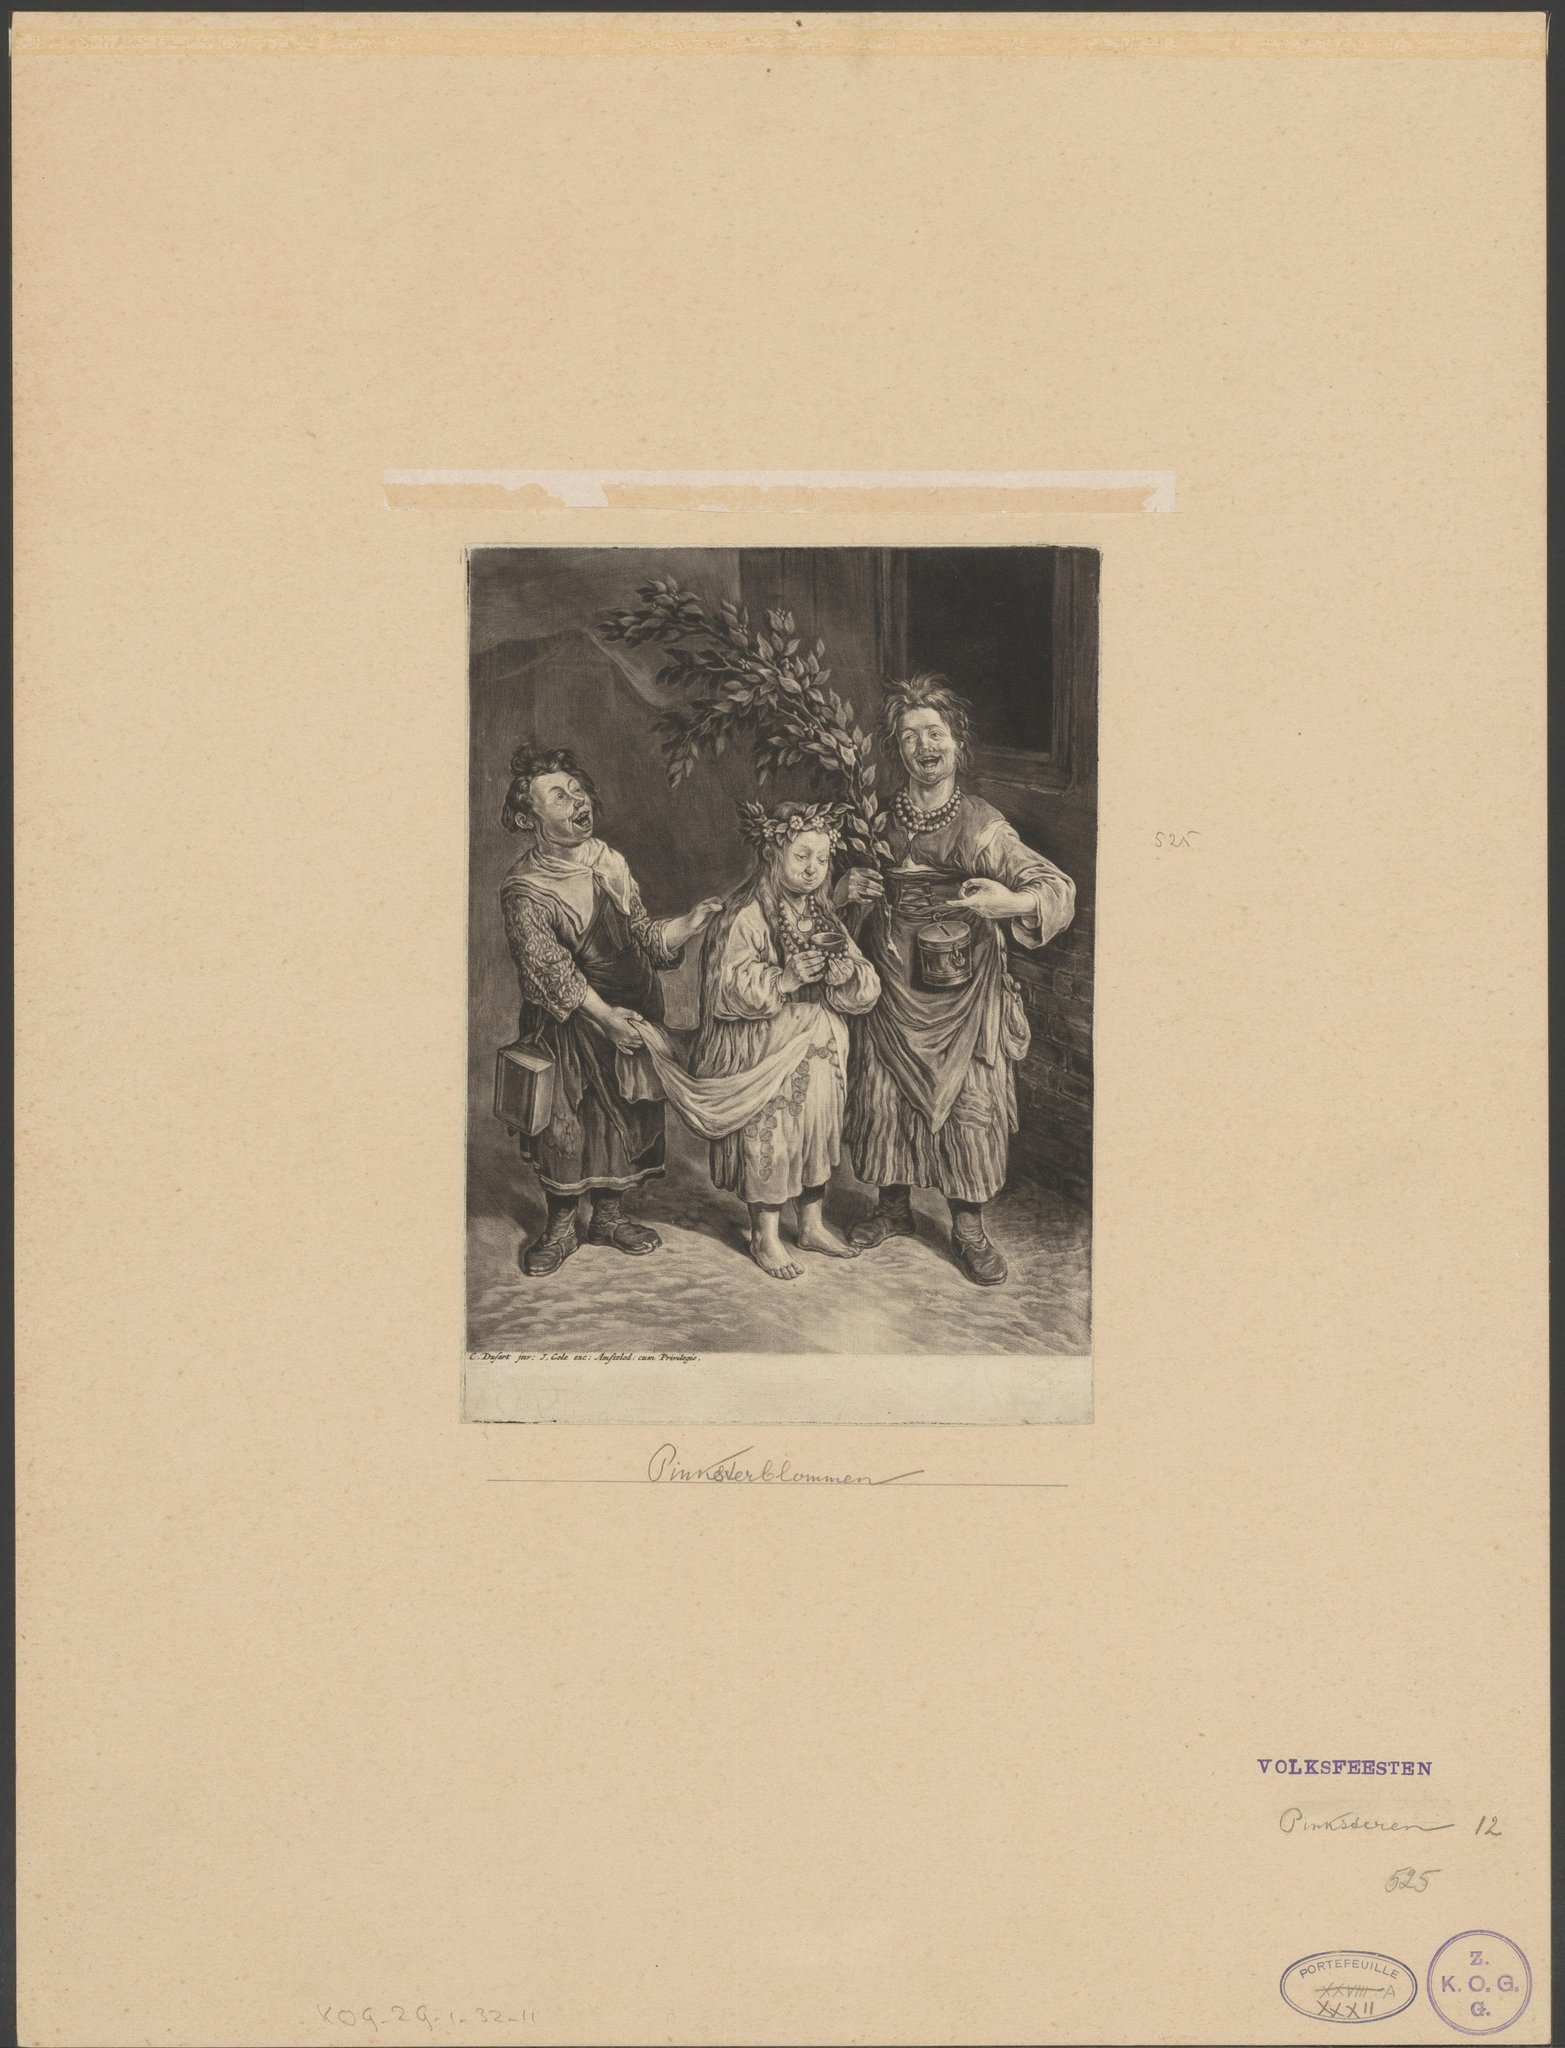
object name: print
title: De twaalf maanden van het jaar, "Les XII Mois de l'Année"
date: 1679-1704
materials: paper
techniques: engraving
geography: amsterdam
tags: flowers, june and its 'labours', children singing, vocal popular music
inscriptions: collector's mark, collector's mark: Lugt 1641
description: Een pinksterblom (pinksterbloem of pinksterbruid), een in een lang gewaad gestoken, met bloemen en sieraden getooid meisje, wordt begeleid door twee verklede kinderen. Samen trekken ze er met Pinksteren op uit om geld op te halen met het zingen van liedjes. De prent maakt deel uit van een serie van twaalf prenten met de twaalf maanden van het jaar. Onderwerpsrubrieken binnen de Atlas Zeden en Gewoonten: Volksfeesten; Pinksteren.